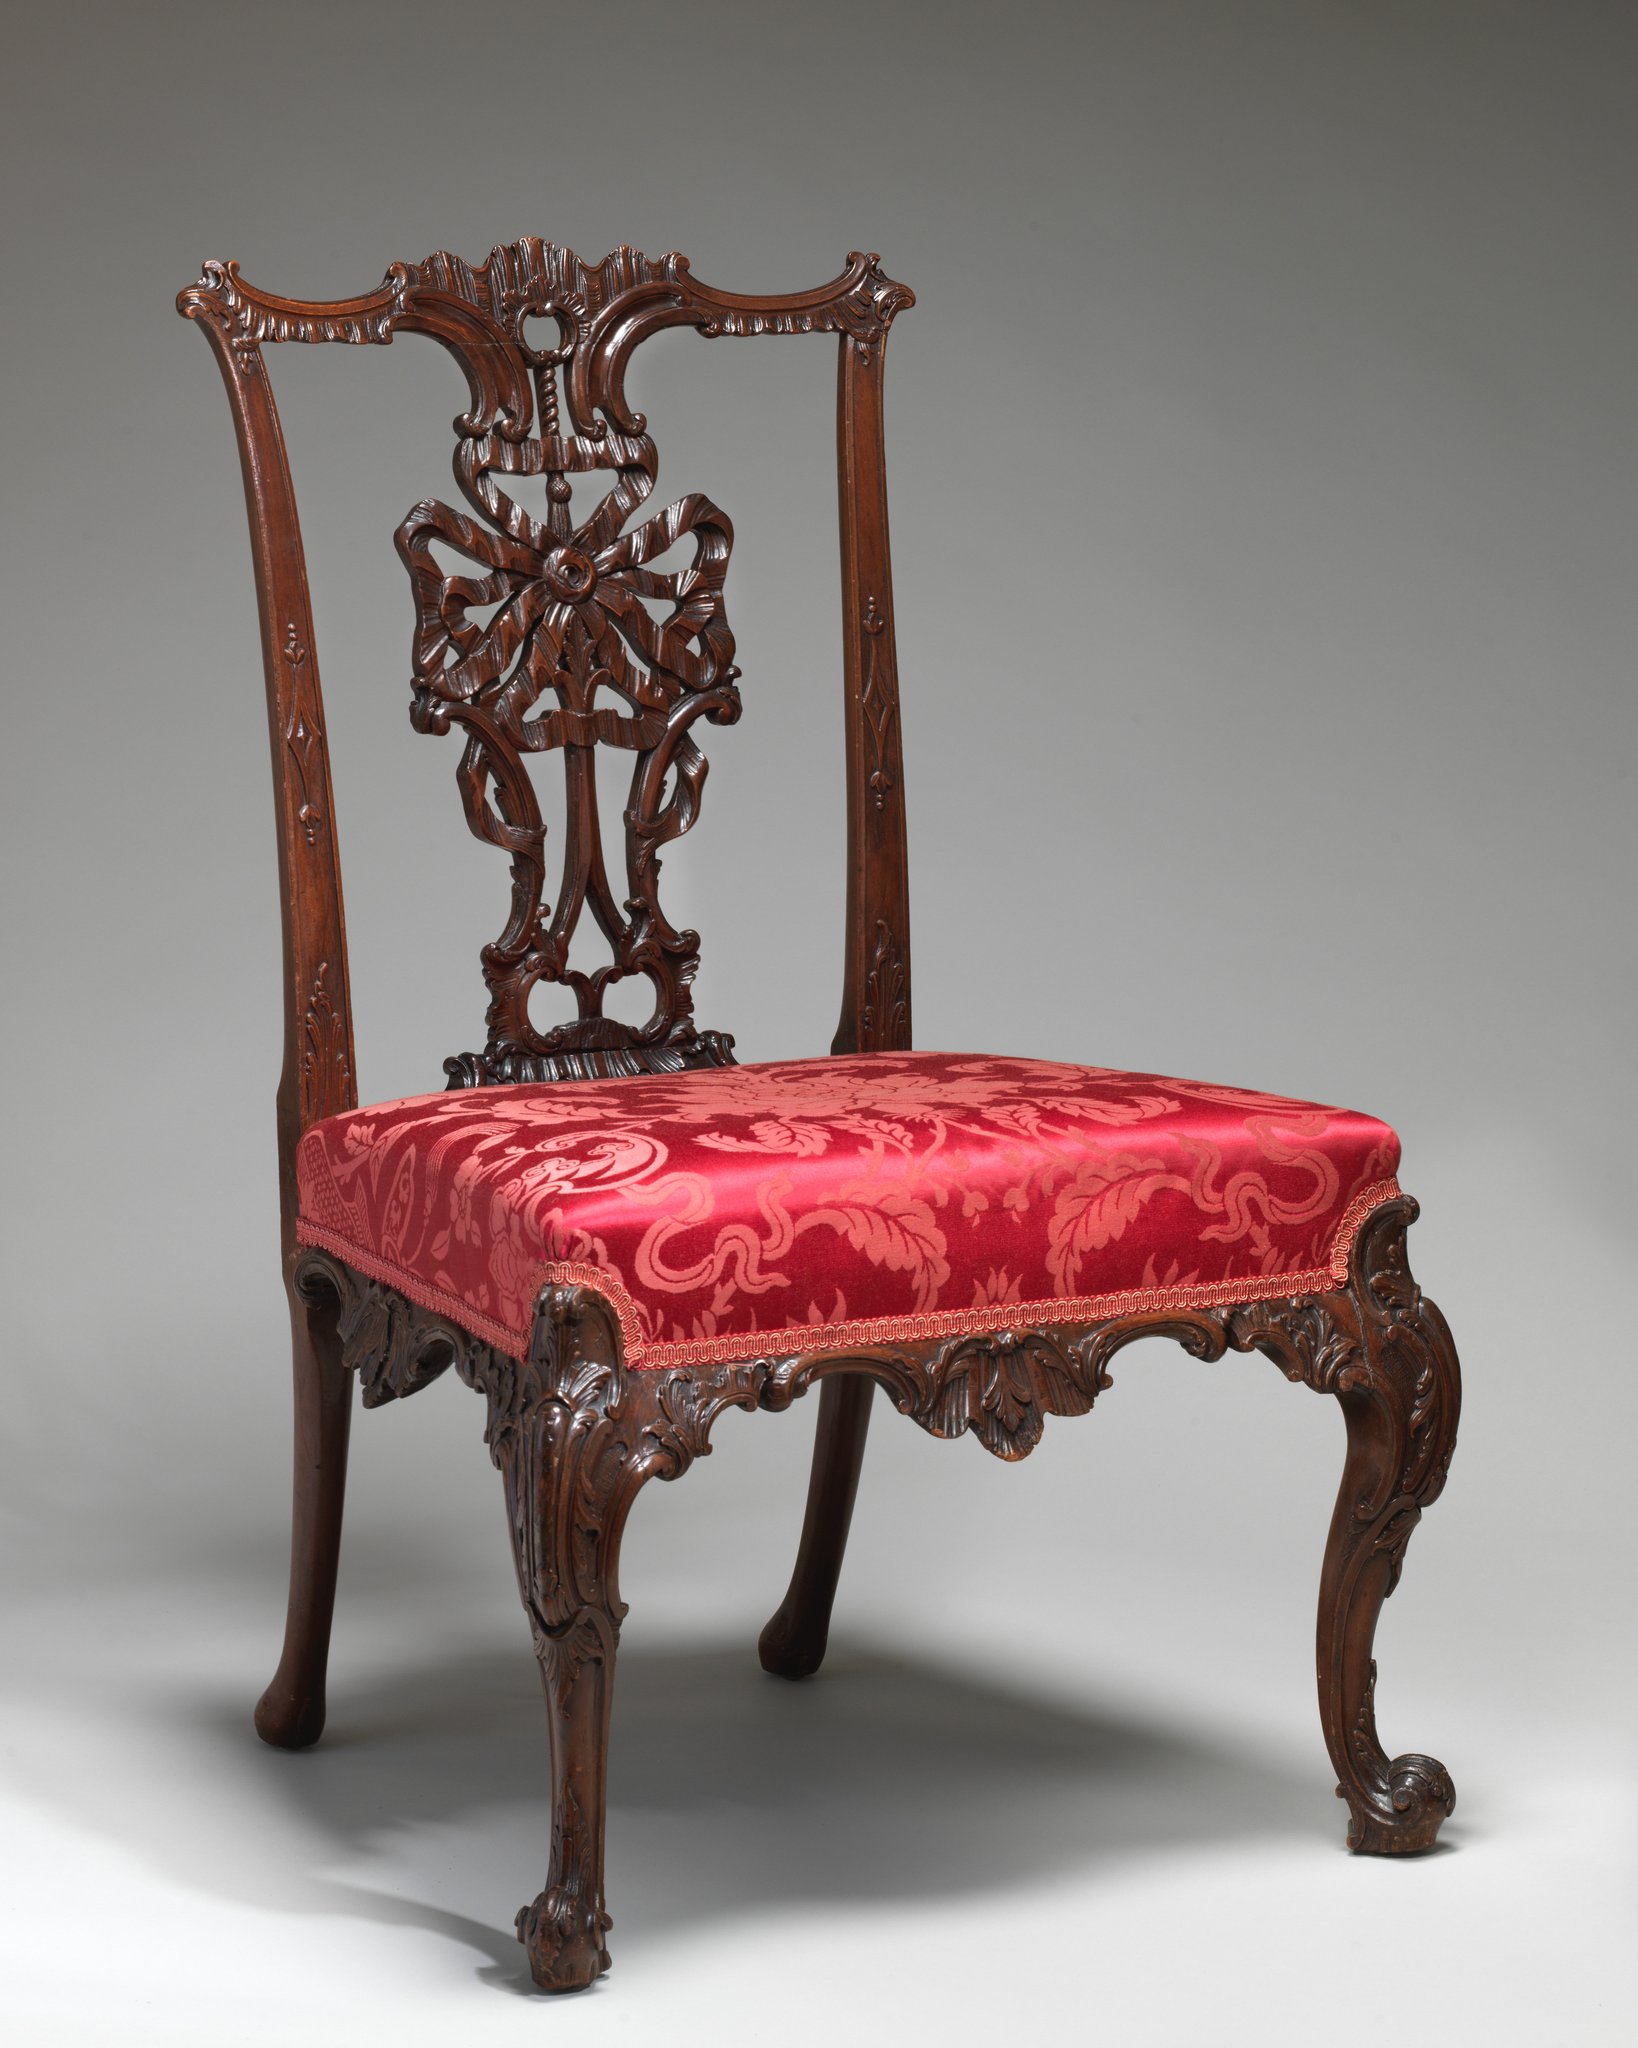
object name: side chair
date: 1734-1766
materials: wood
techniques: damask